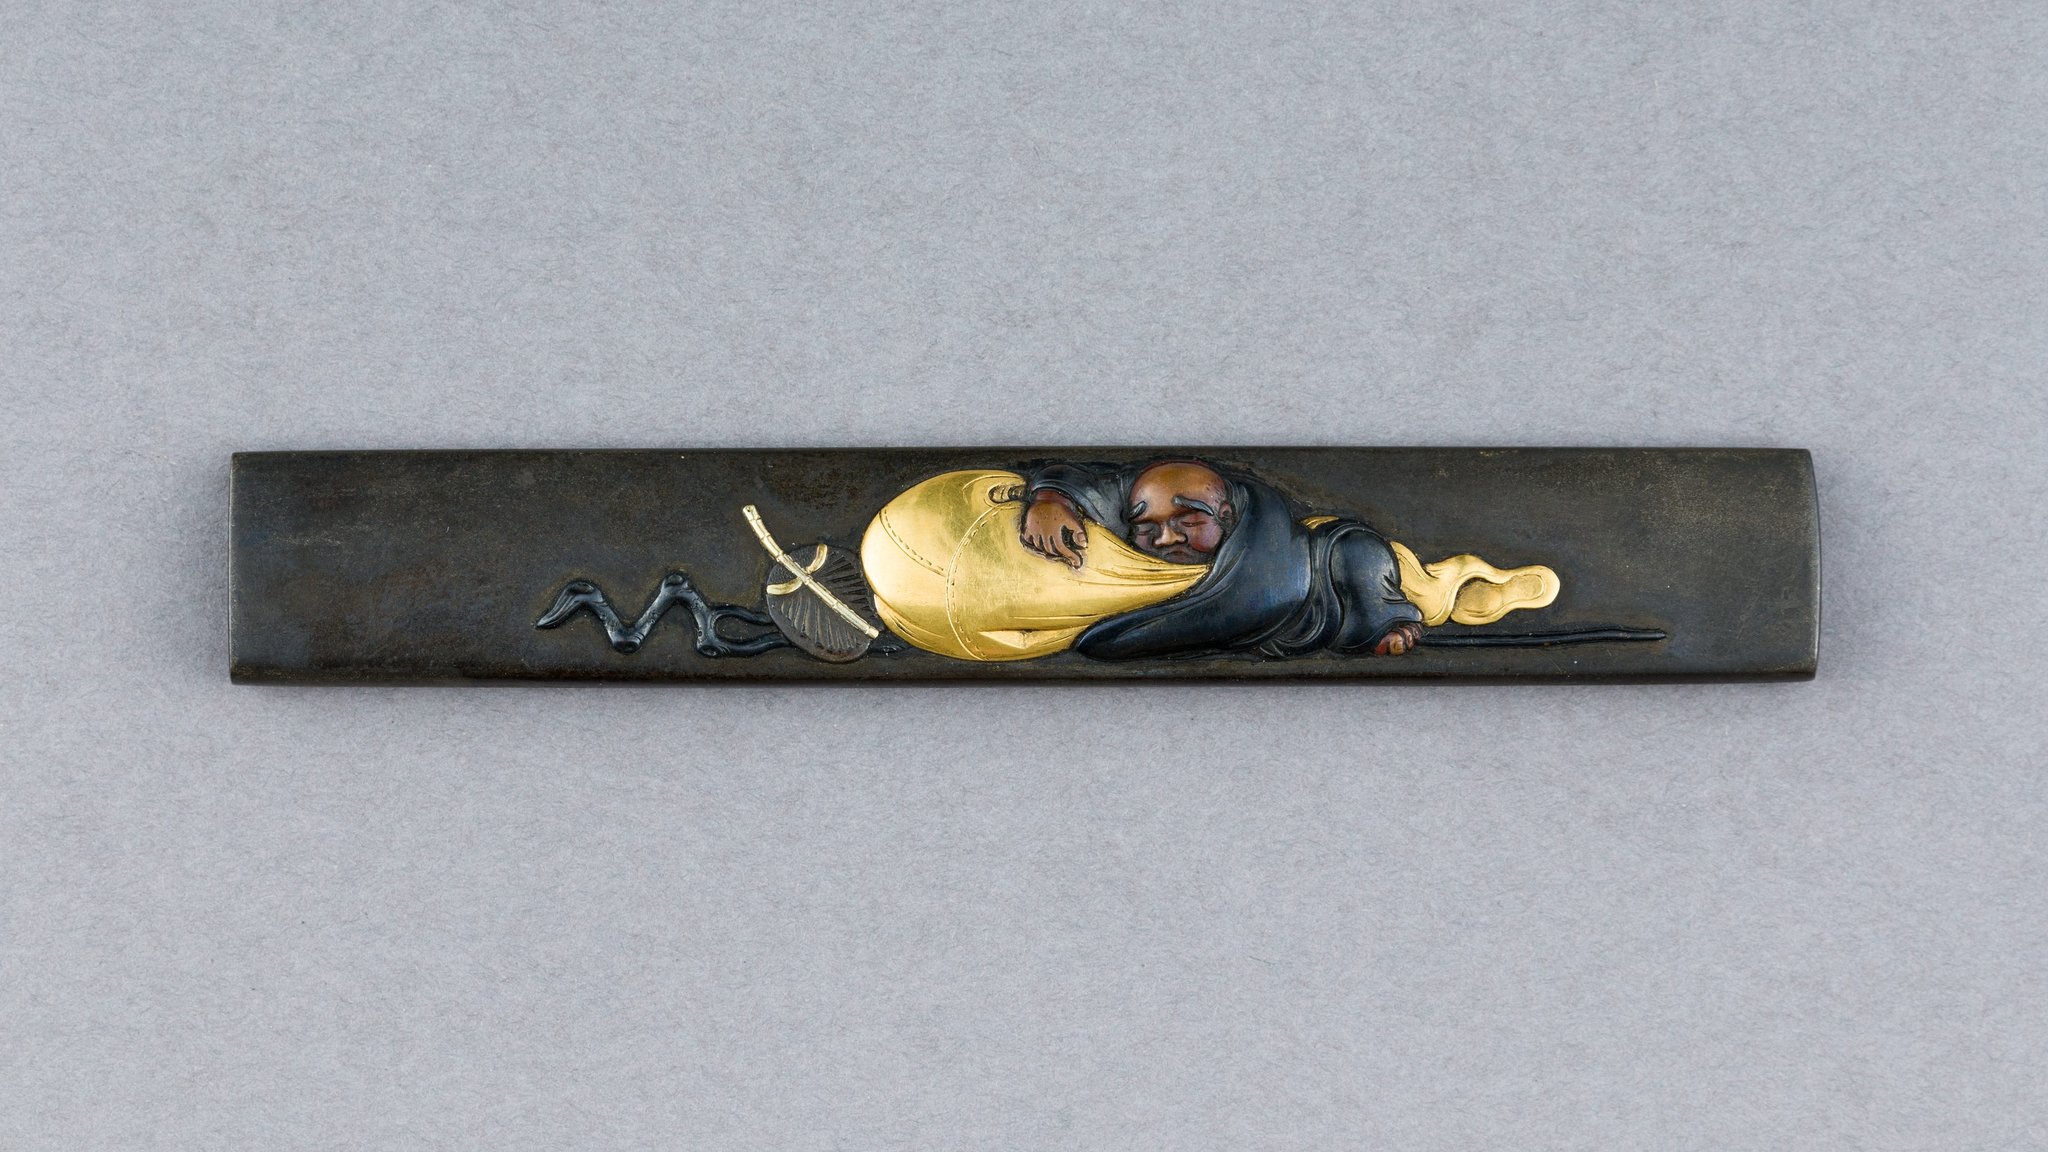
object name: knife handle kozuka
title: Knife Handle (Kozuka)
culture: japanese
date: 1615-1868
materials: copper, gold alloy, silver alloy, gold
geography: japan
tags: sleeping,men